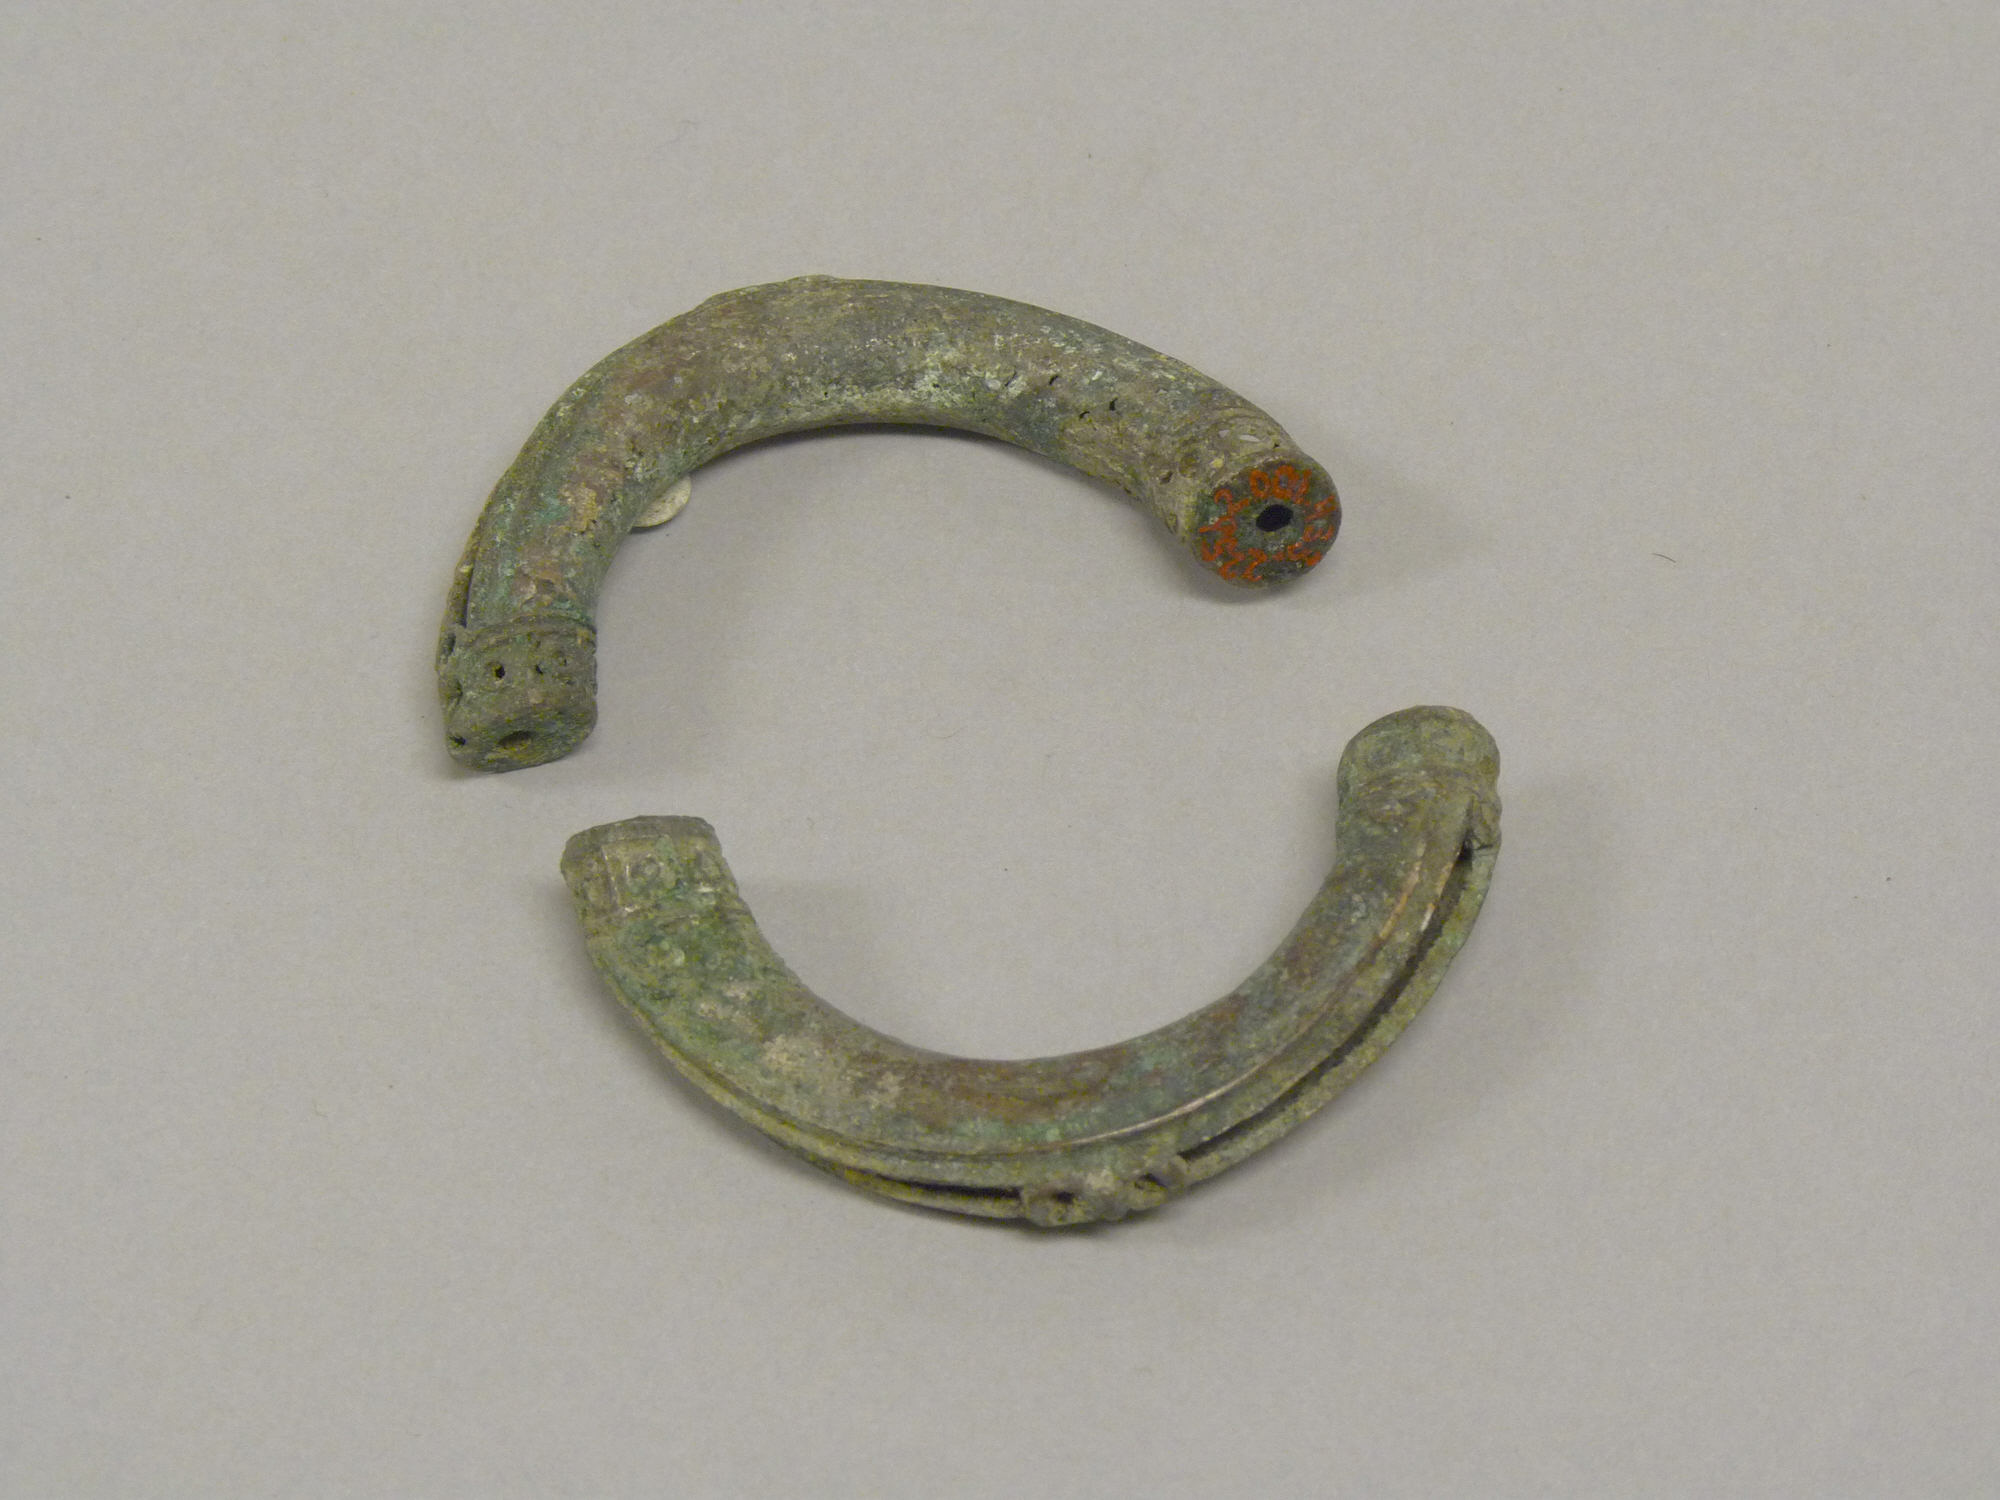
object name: bangle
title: Hollow Bangle in Two Parts with Pellets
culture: thai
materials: bronze